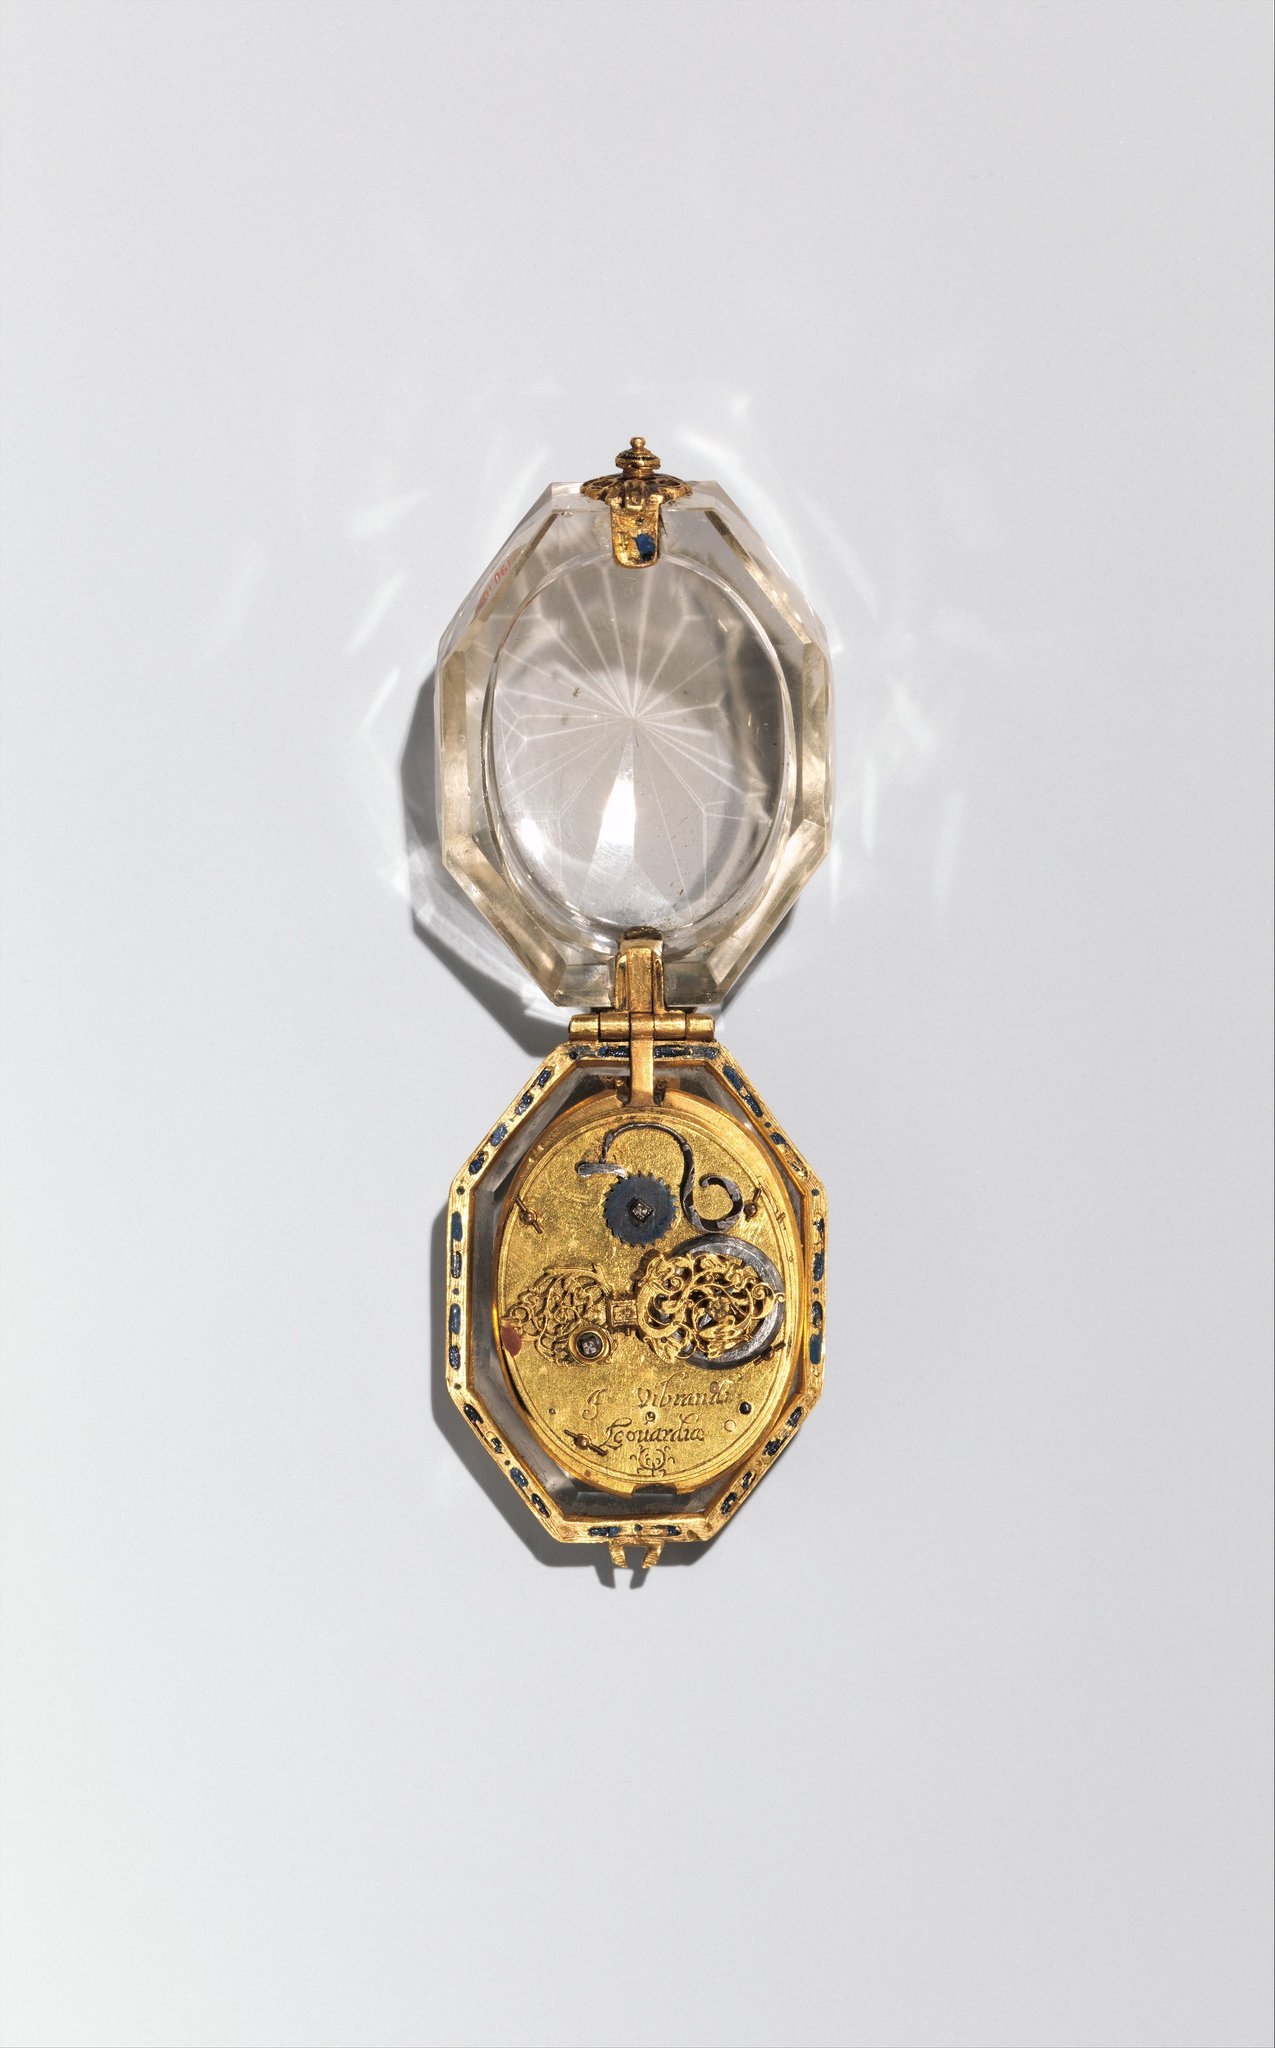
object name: watch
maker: jacob wybrants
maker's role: maker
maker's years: 1635-1678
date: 1640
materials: gilt brass, gold, quartz, steel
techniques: enamel